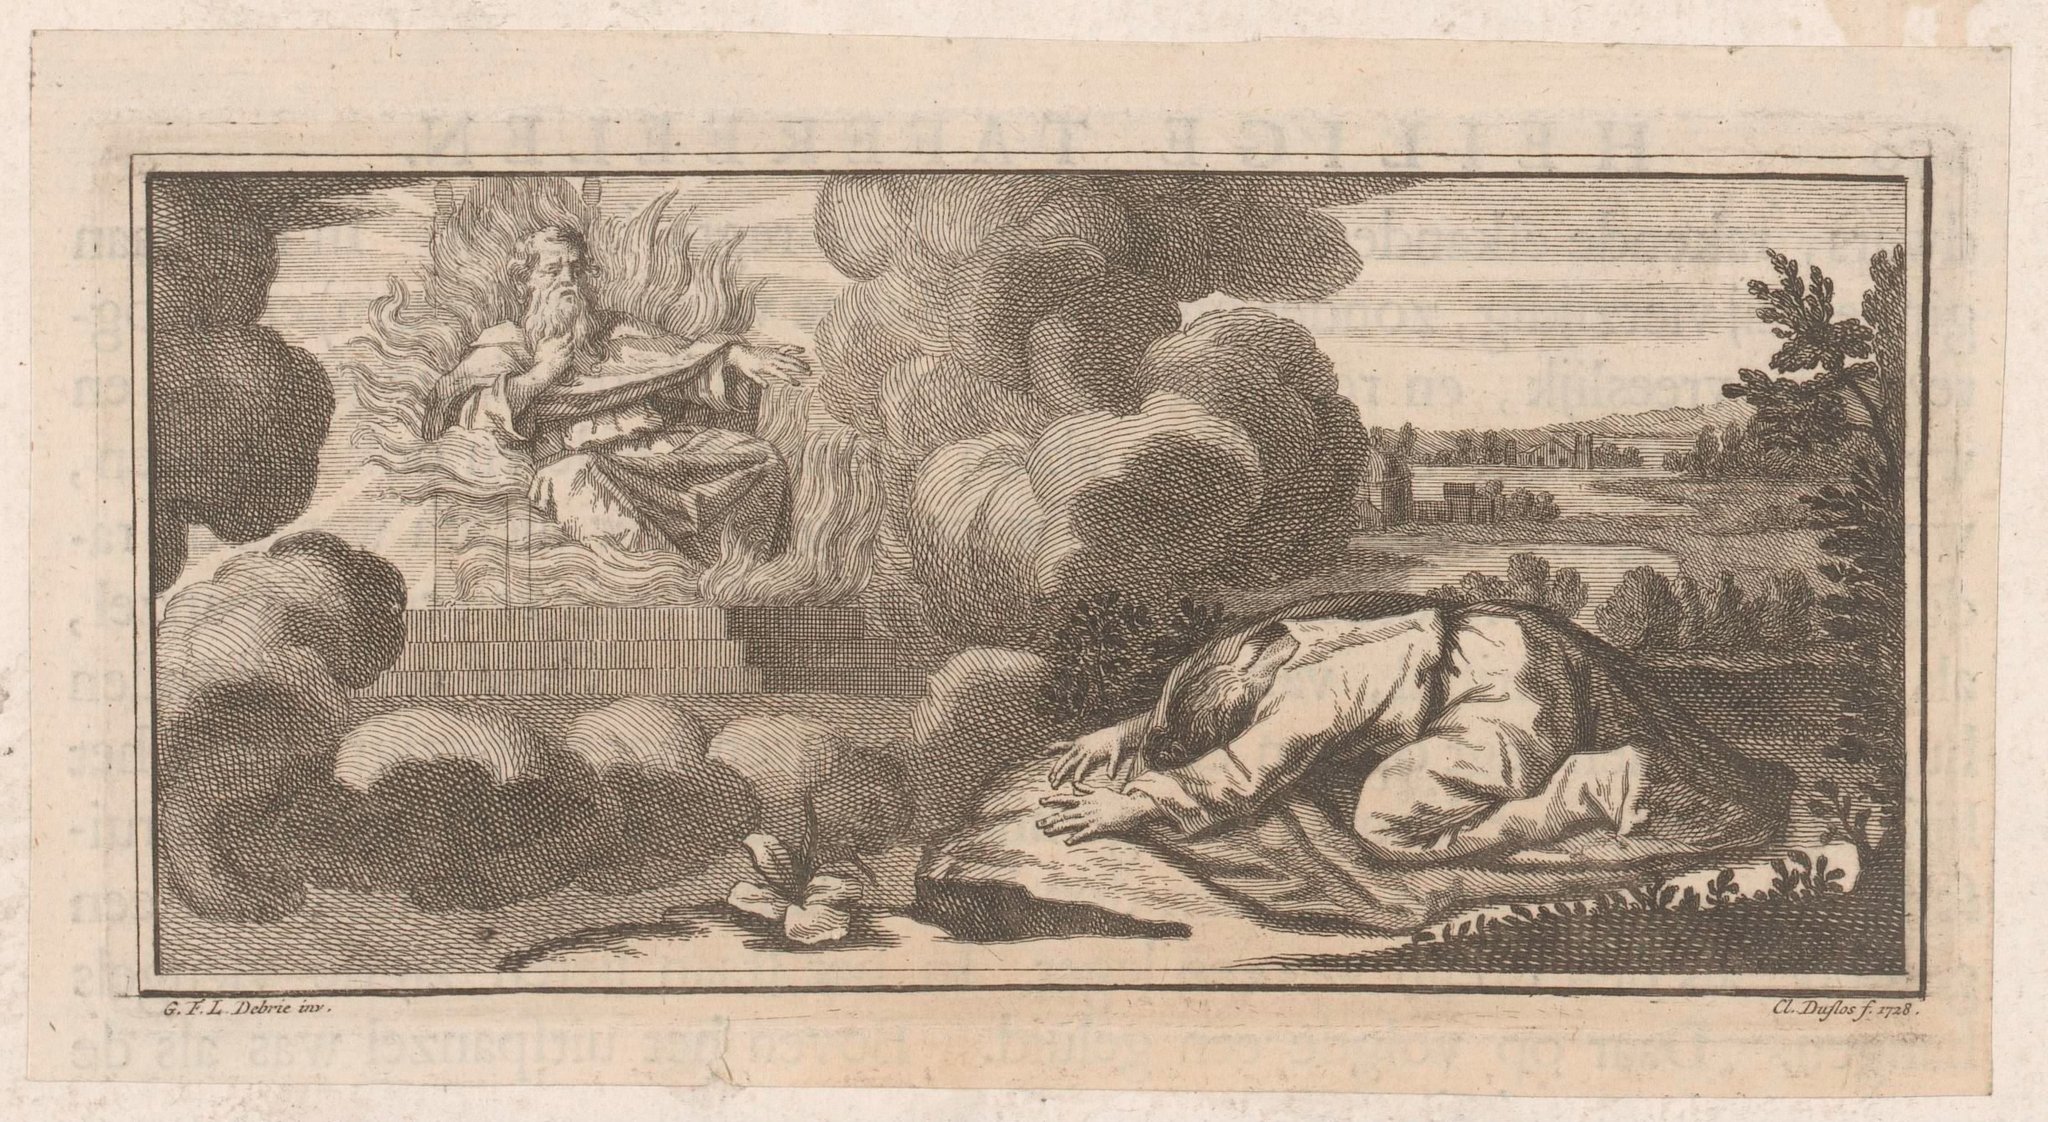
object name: print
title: Allegorische of Bijbelse voorstelling met knielende figuur voor man op troon met vlammen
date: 1728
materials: paper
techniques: engraving, etching, letterpress printing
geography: france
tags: old man, kneeling figure, flame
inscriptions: collector's mark: Lugt 2228